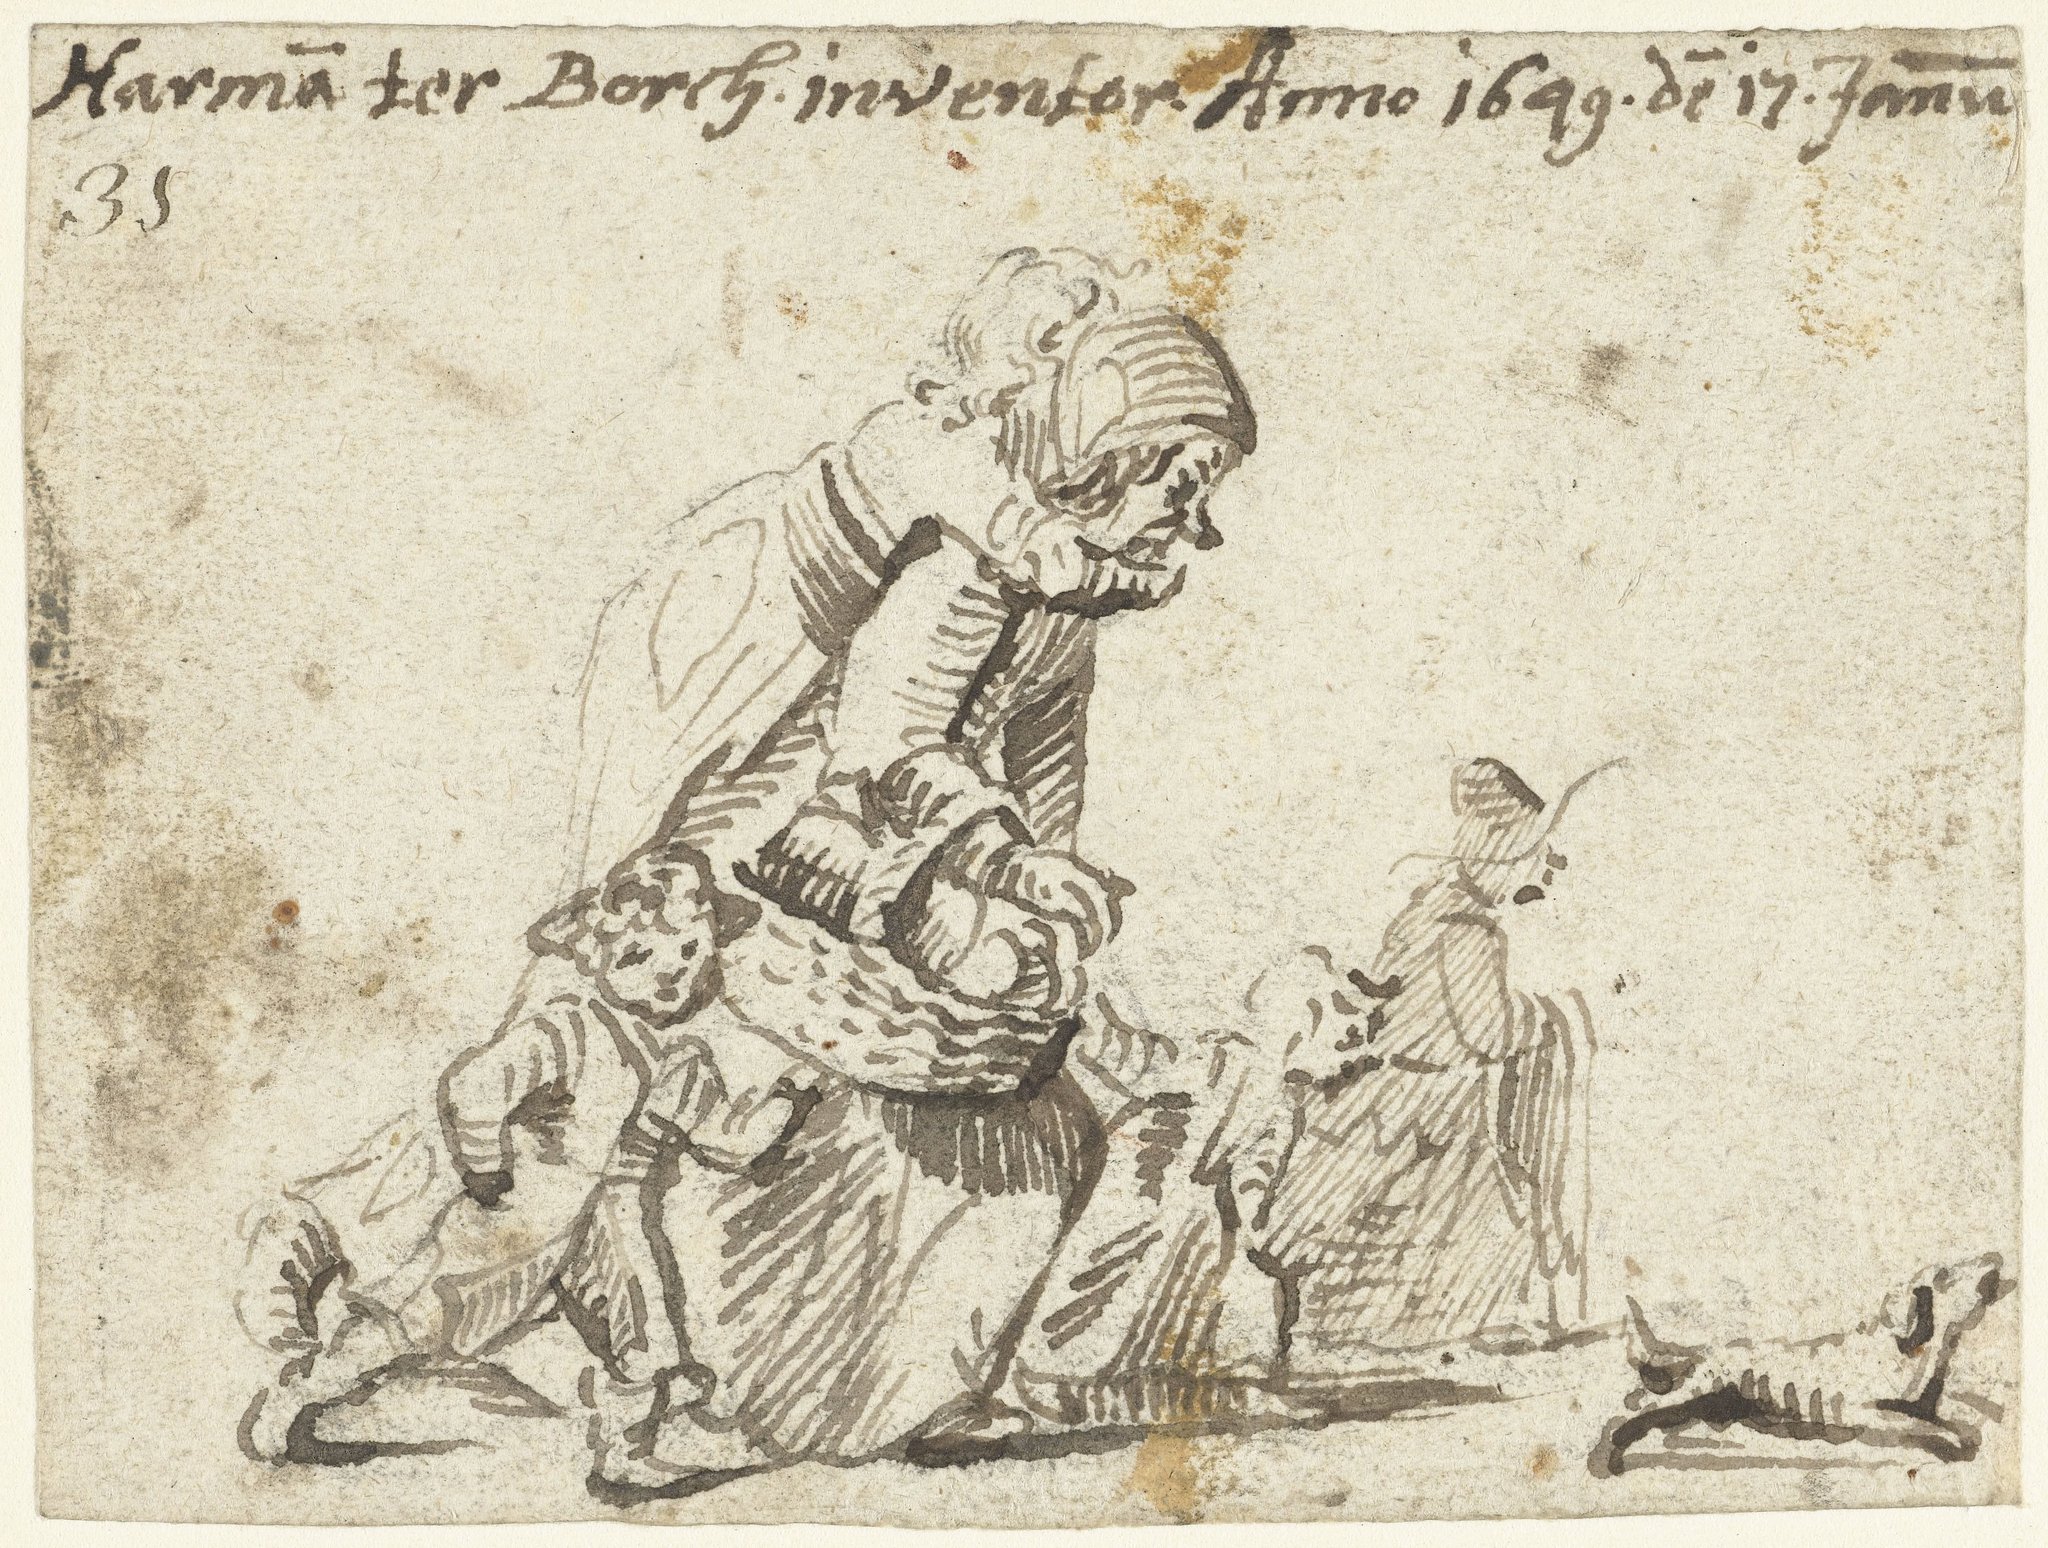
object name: drawing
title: Vrouw lopend met vier kinderen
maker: harmen ter borch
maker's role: draughtsman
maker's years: 1638-1677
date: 1649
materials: chalk, ink, paper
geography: zwolle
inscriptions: number: ‘31’, annotation: ‘Harma[n] ter Borch.inventor. Anno 1649. de[n] 17.Janu[ary]’